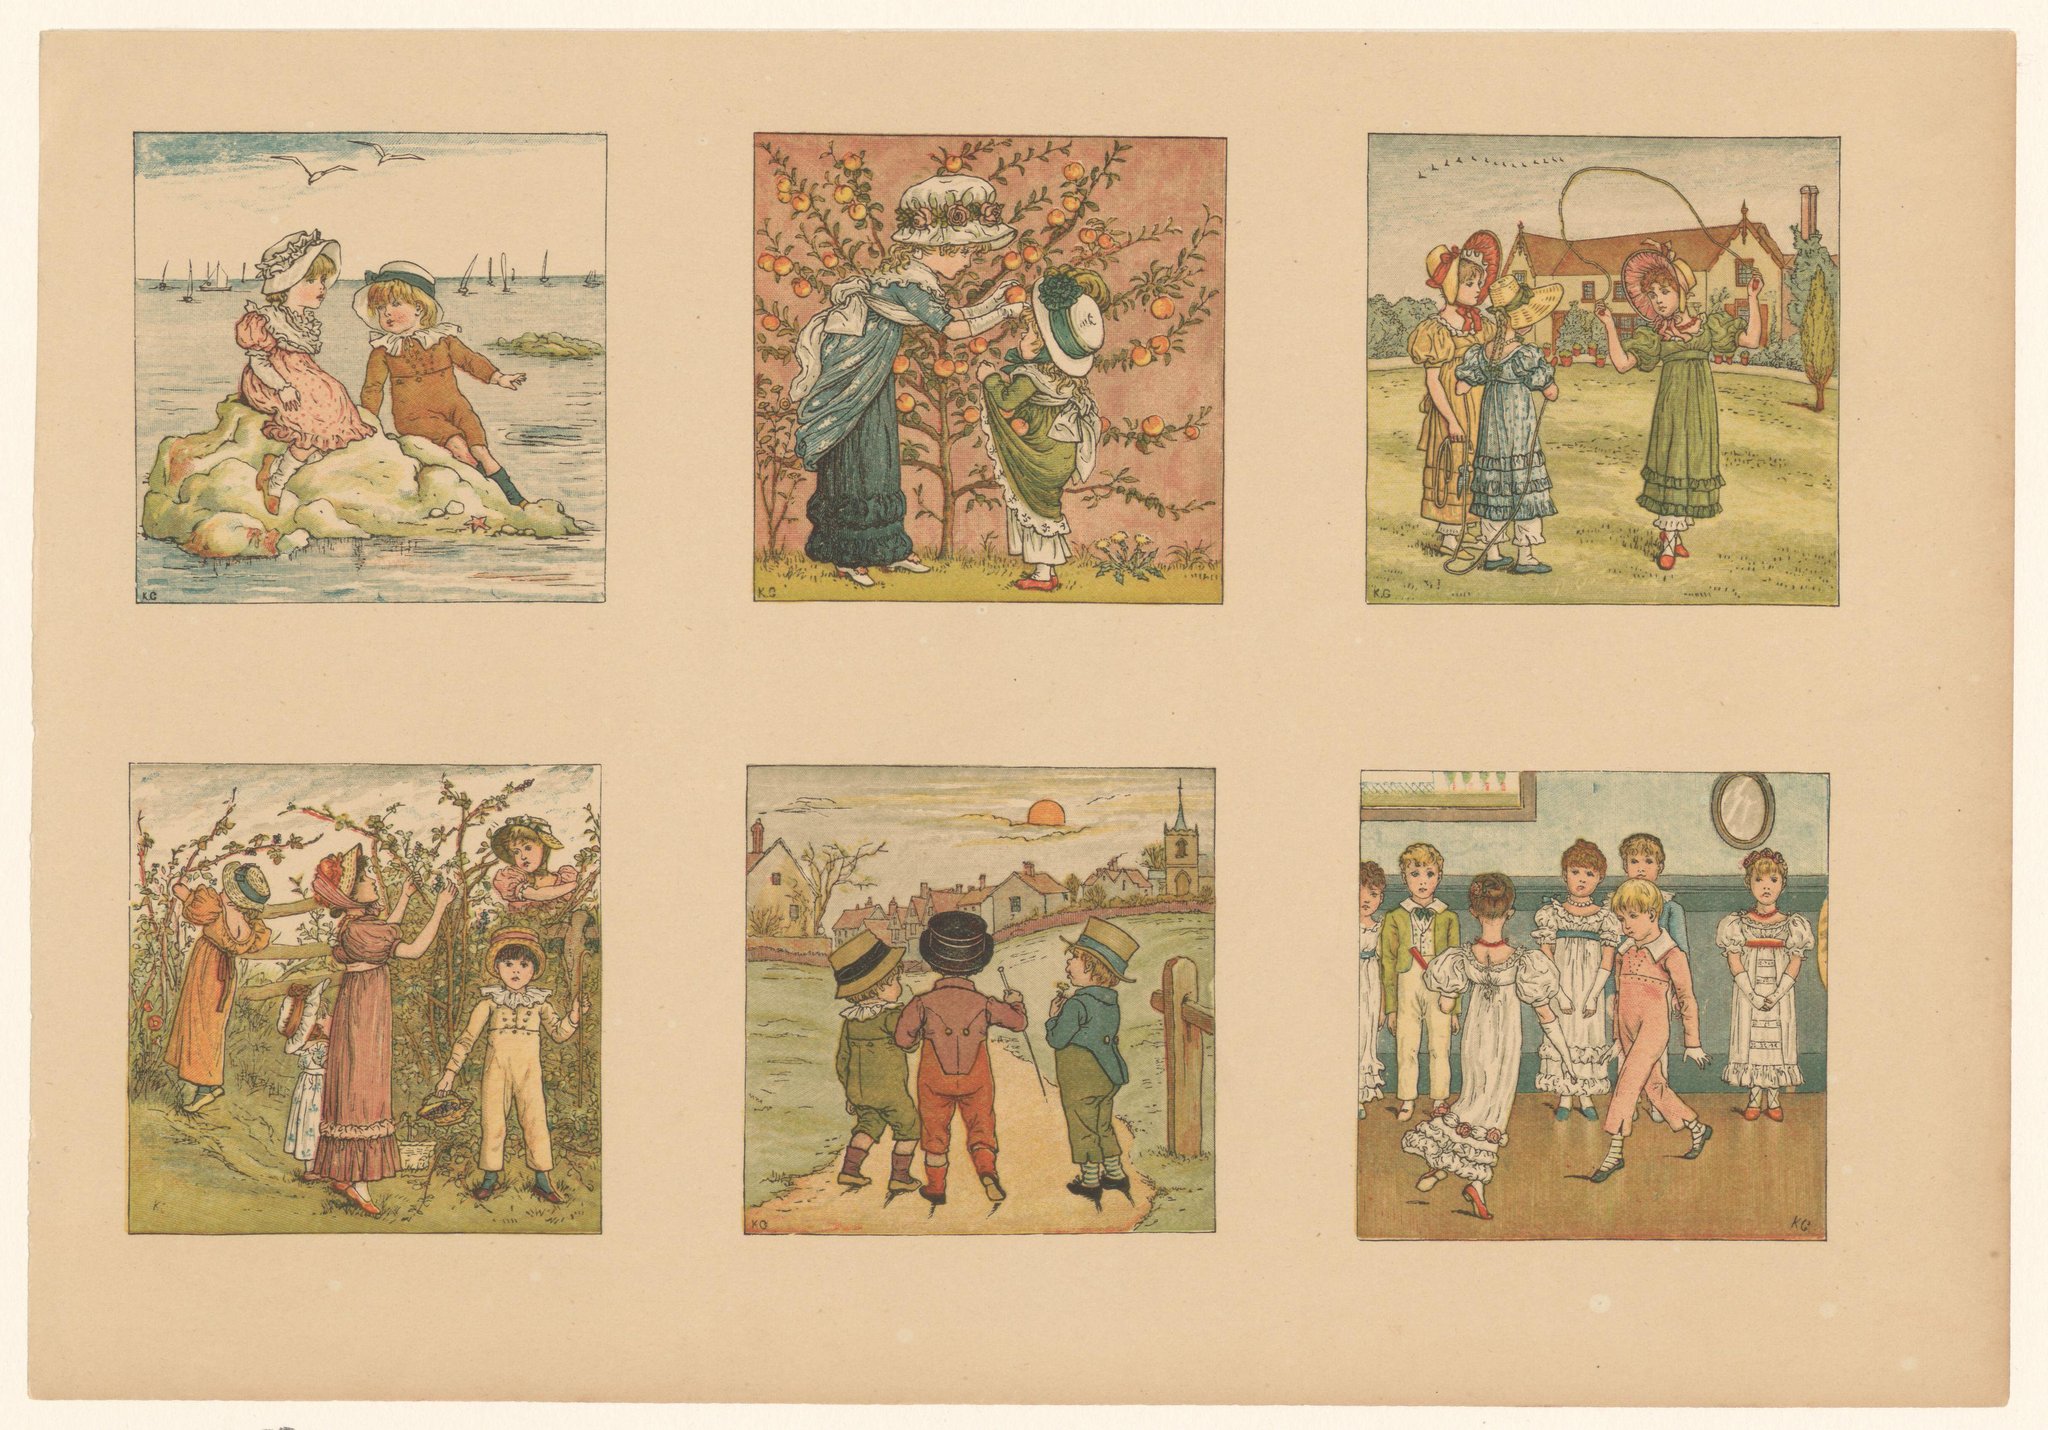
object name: print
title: Zes voorstellingen van kinderen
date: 1880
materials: paper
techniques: wood engraving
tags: children's games and plays, child (+ more than eight persons)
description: De zes voorstellingen zijn afzonderlijk gepubliceerd in: Greenaway, Kate en Sale Barker. Birthday book for children. Londen: George Routledge & Sons, 1880.